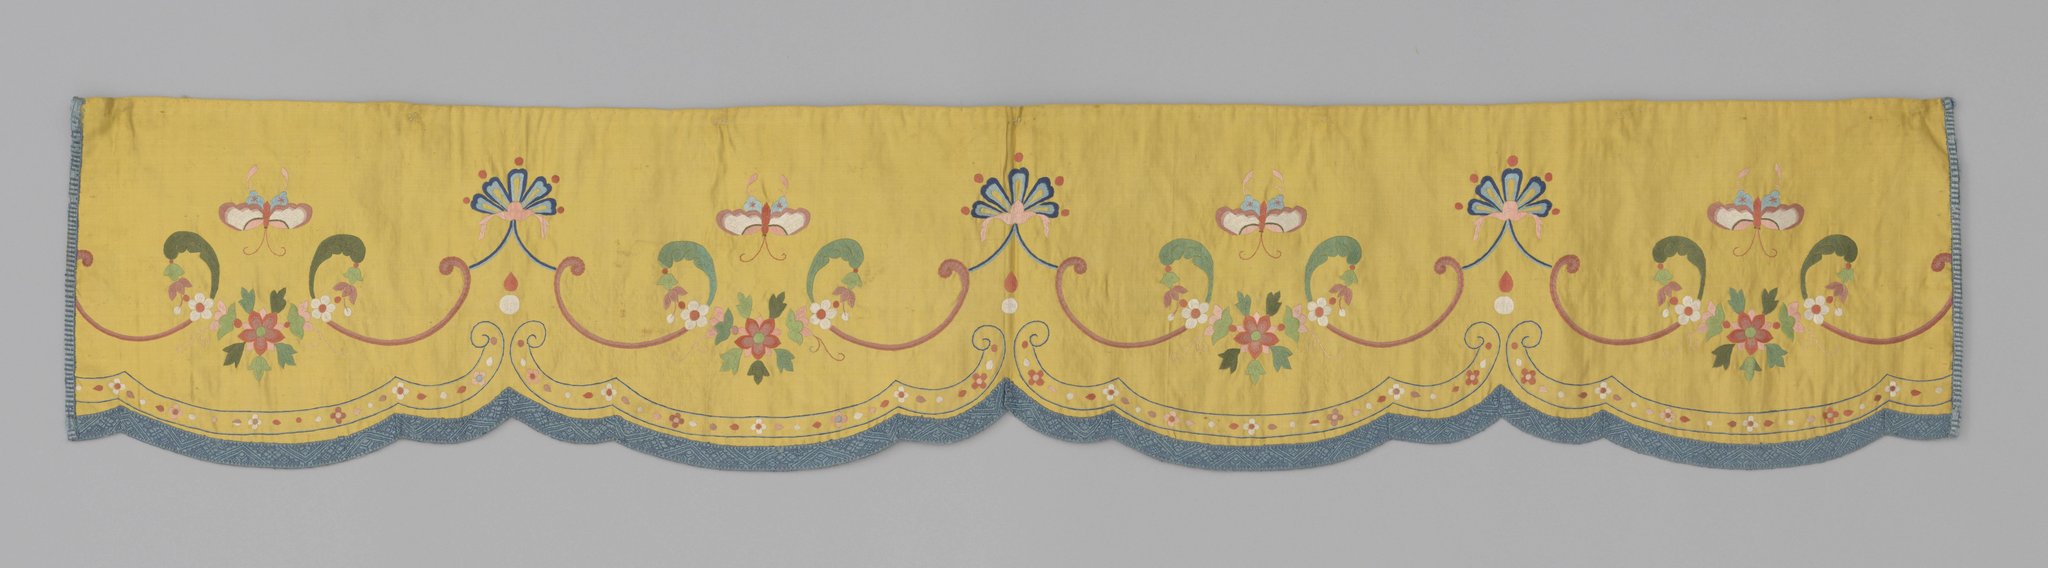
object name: lambrequin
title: Lambrekijn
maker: Anonymous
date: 1720-1740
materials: linen, silk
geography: guangdong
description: Geel zijden lambrekijn van een bedgarnituur geborduurd met bloemen en vlinders in veelkleurige zijde, omboord en versierd met blauw passement, gevoerd met grof linnen en gele zijde. Bestemd voor de voorkant van het bed, binnenkant.